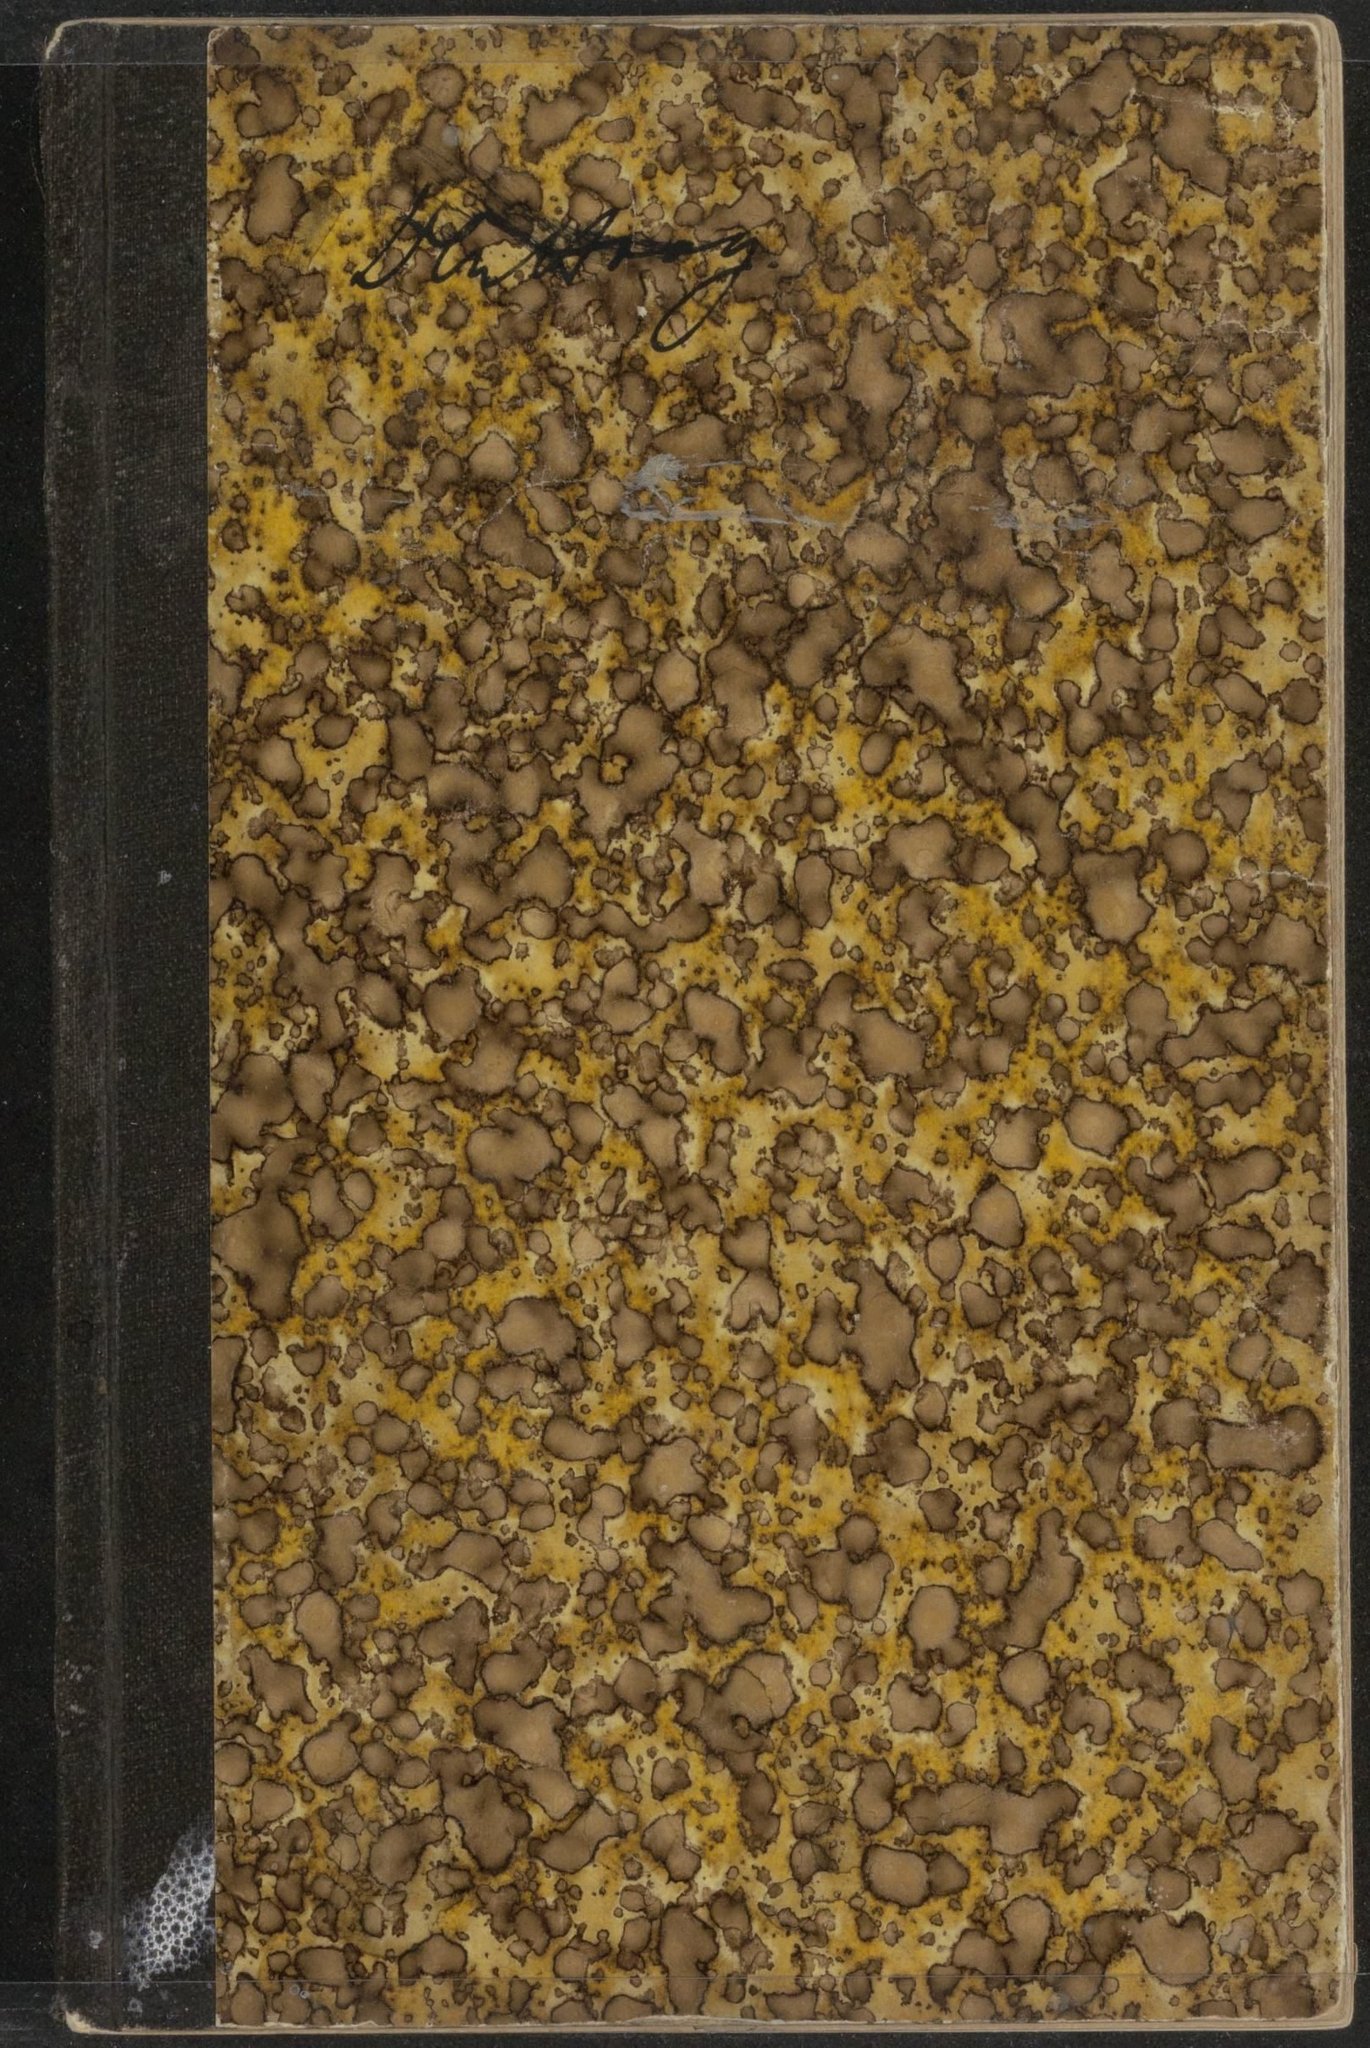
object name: sketchbook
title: Schetsboek met 18 bladen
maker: george hendrik breitner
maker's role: draughtsman, painter, print maker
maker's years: 1857-1923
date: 1883-1885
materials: cardboard, chalk, linen, paper, pencil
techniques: marbling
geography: the hague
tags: adult woman, adult man, public road, the hague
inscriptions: annotation: ‘Den Haag’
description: Schetsboek bestaande uit 18 bladen met figuurstudies, portretten en stadsgezichten.